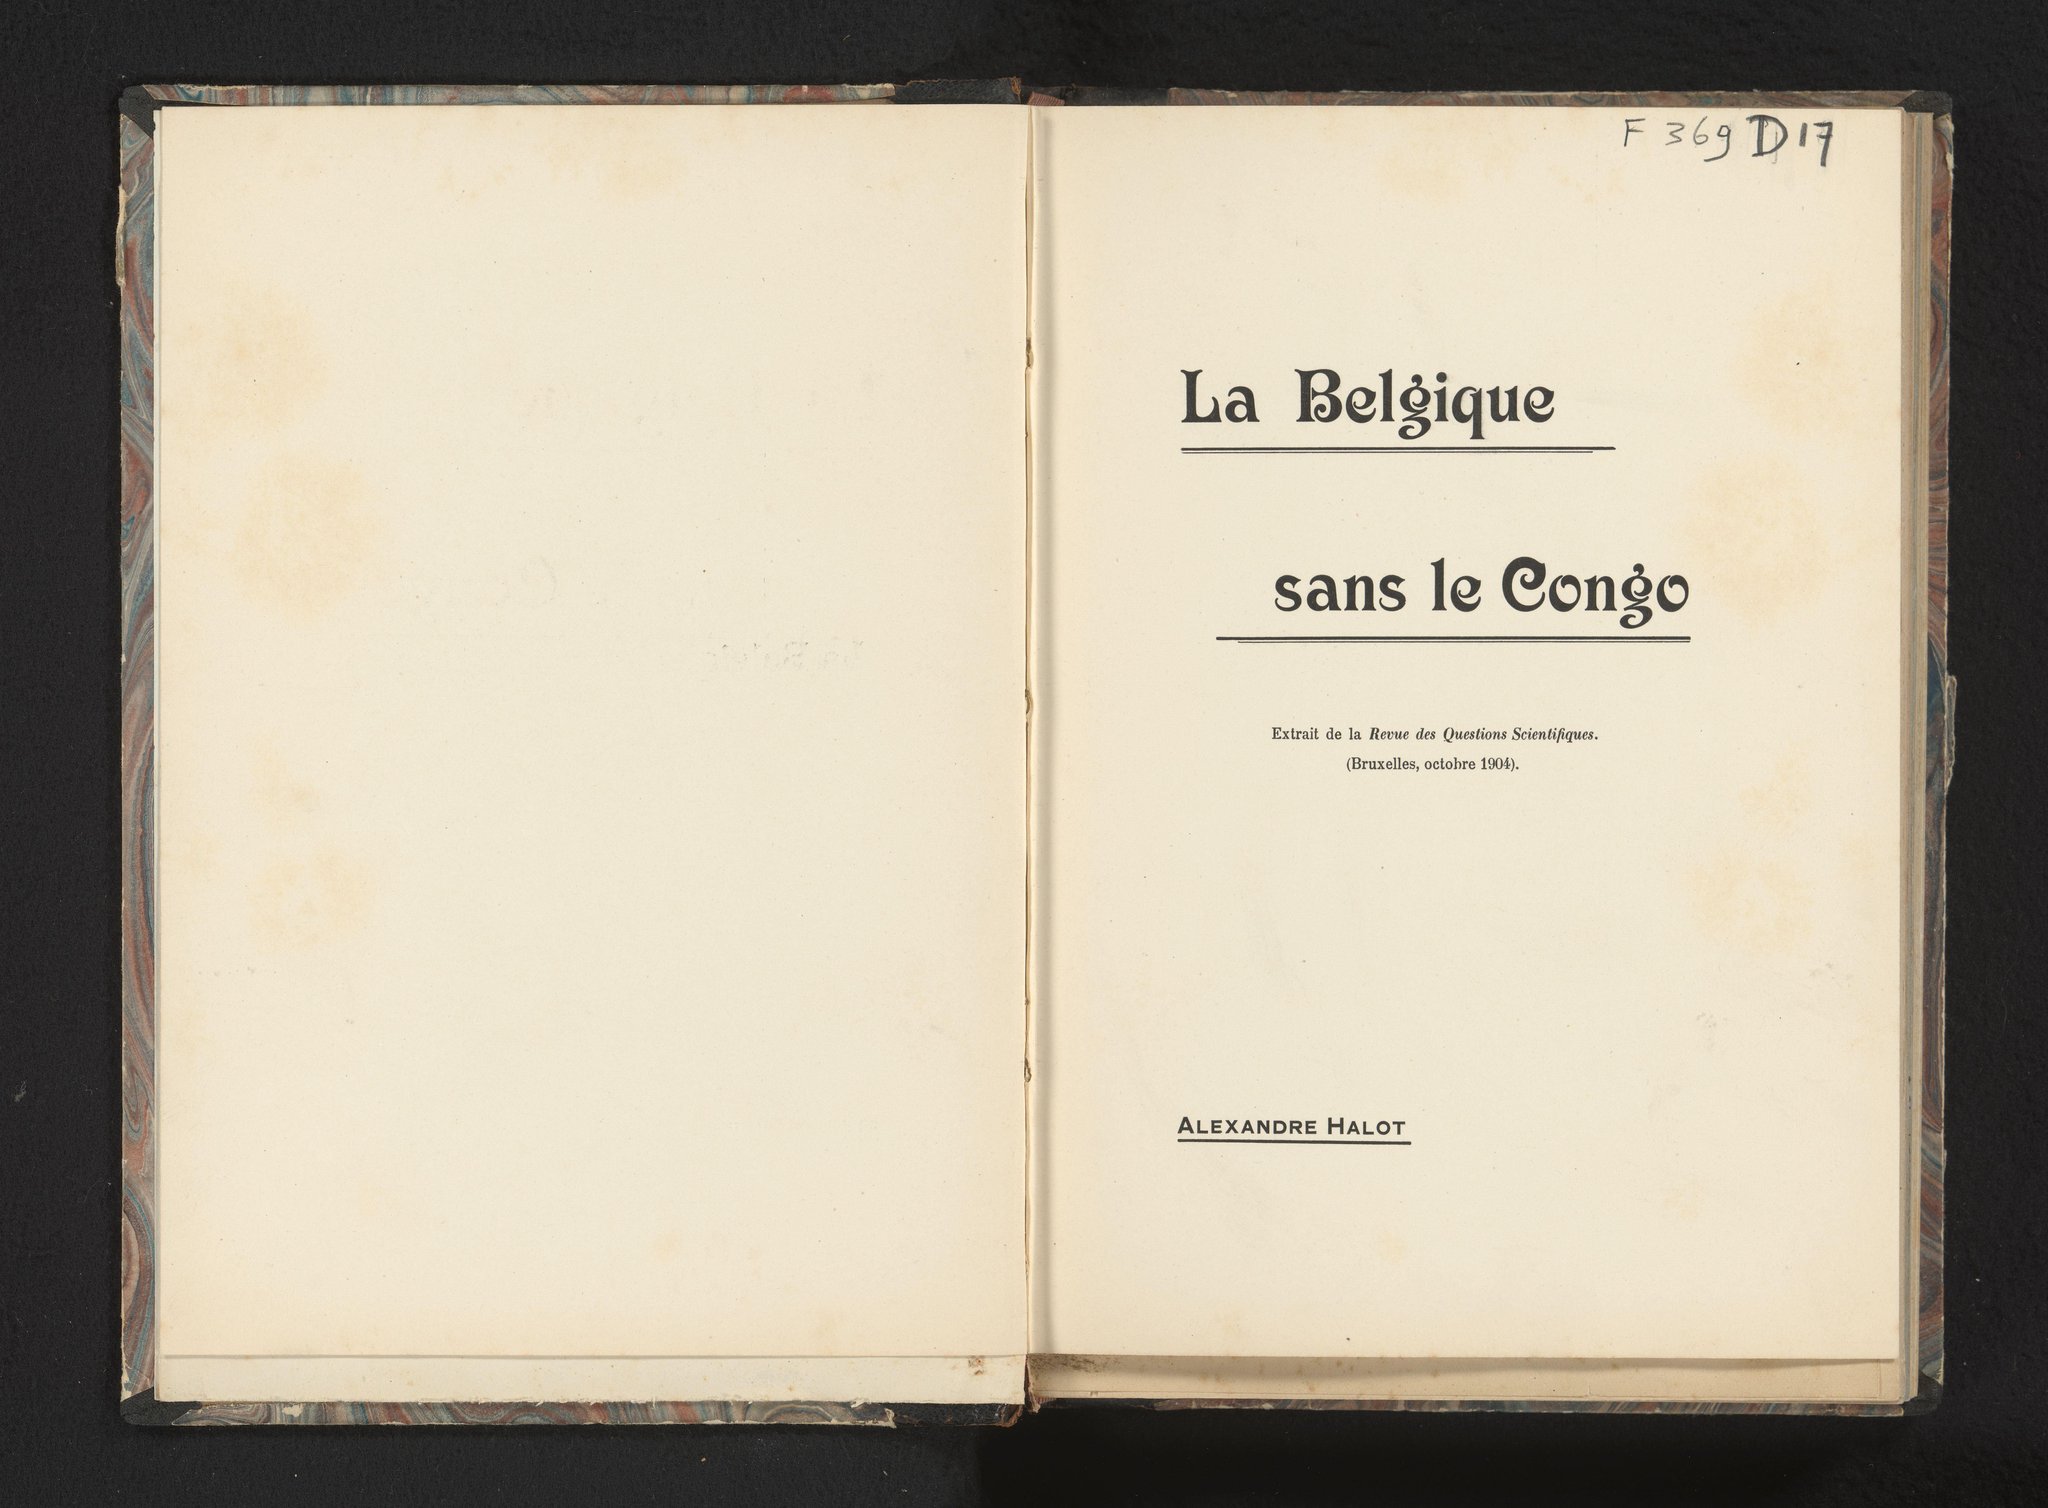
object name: book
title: La Belgique sans le Congo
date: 1904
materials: linen, paper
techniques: printing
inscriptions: number: ‘2.000-’, date: ‘Jan 1992’, bookplate: ‘Comtede Kerchove de Denterghem’